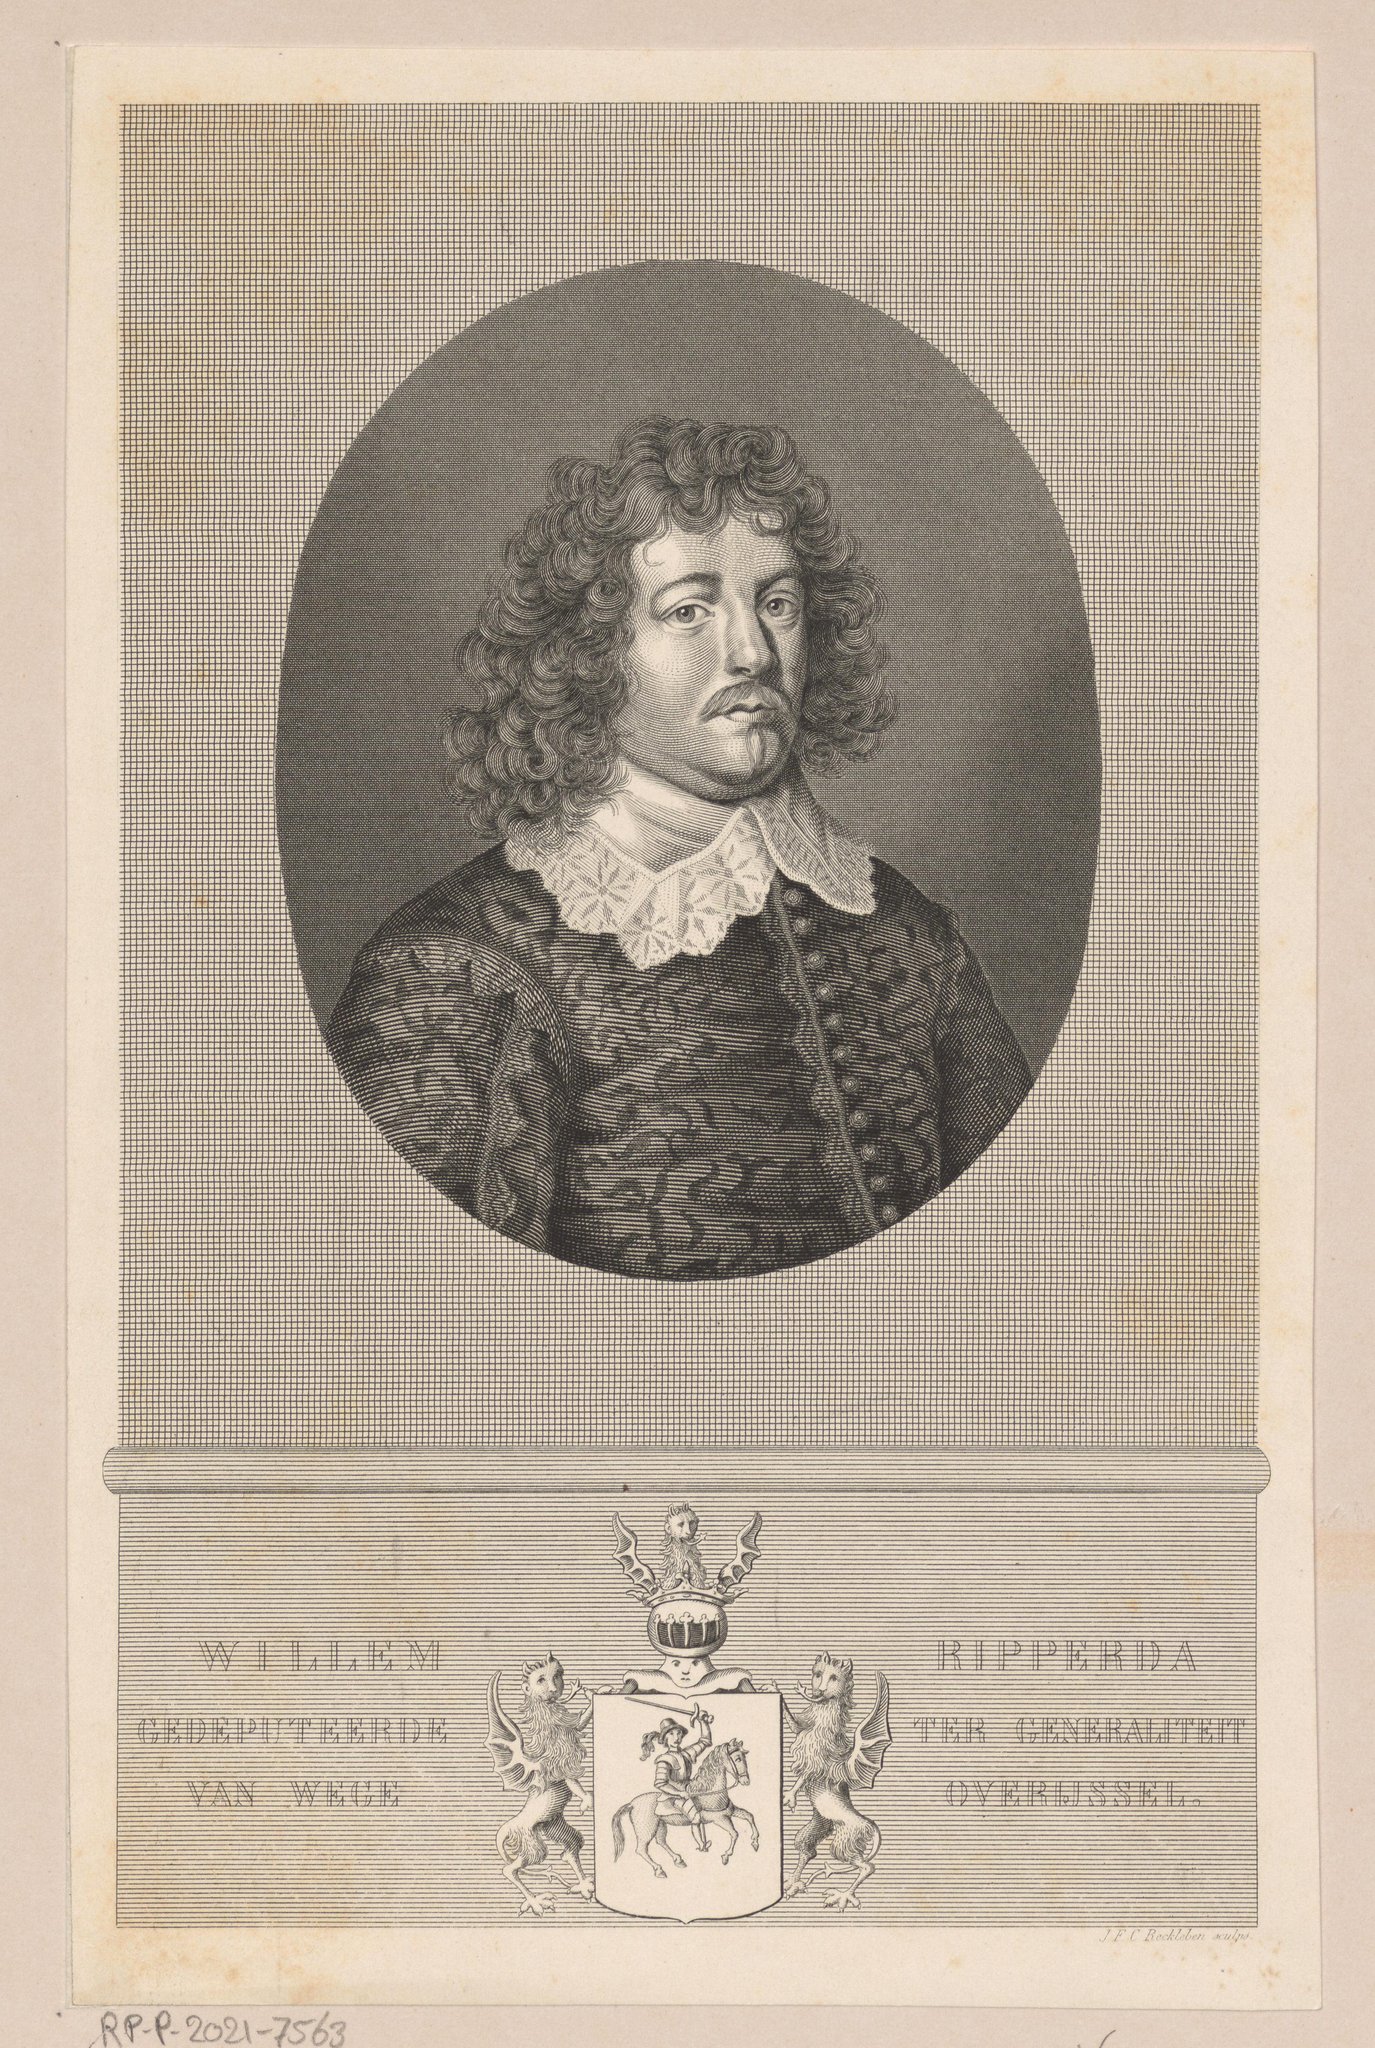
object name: print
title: Portret van Willem van Ripperda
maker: jan frederik christiaan reckleben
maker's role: print maker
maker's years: 1819-1879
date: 1857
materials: paper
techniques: engraving, etching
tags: historical persons, armorial bearing, heraldry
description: Prent mogelijk uit: Arend, Johannes Pieter. Algemeene geschiedenis des vaderlands (...). Amsterdam: J.F. Schleijer, 1857, vol. III, dl. 5, p. 268.